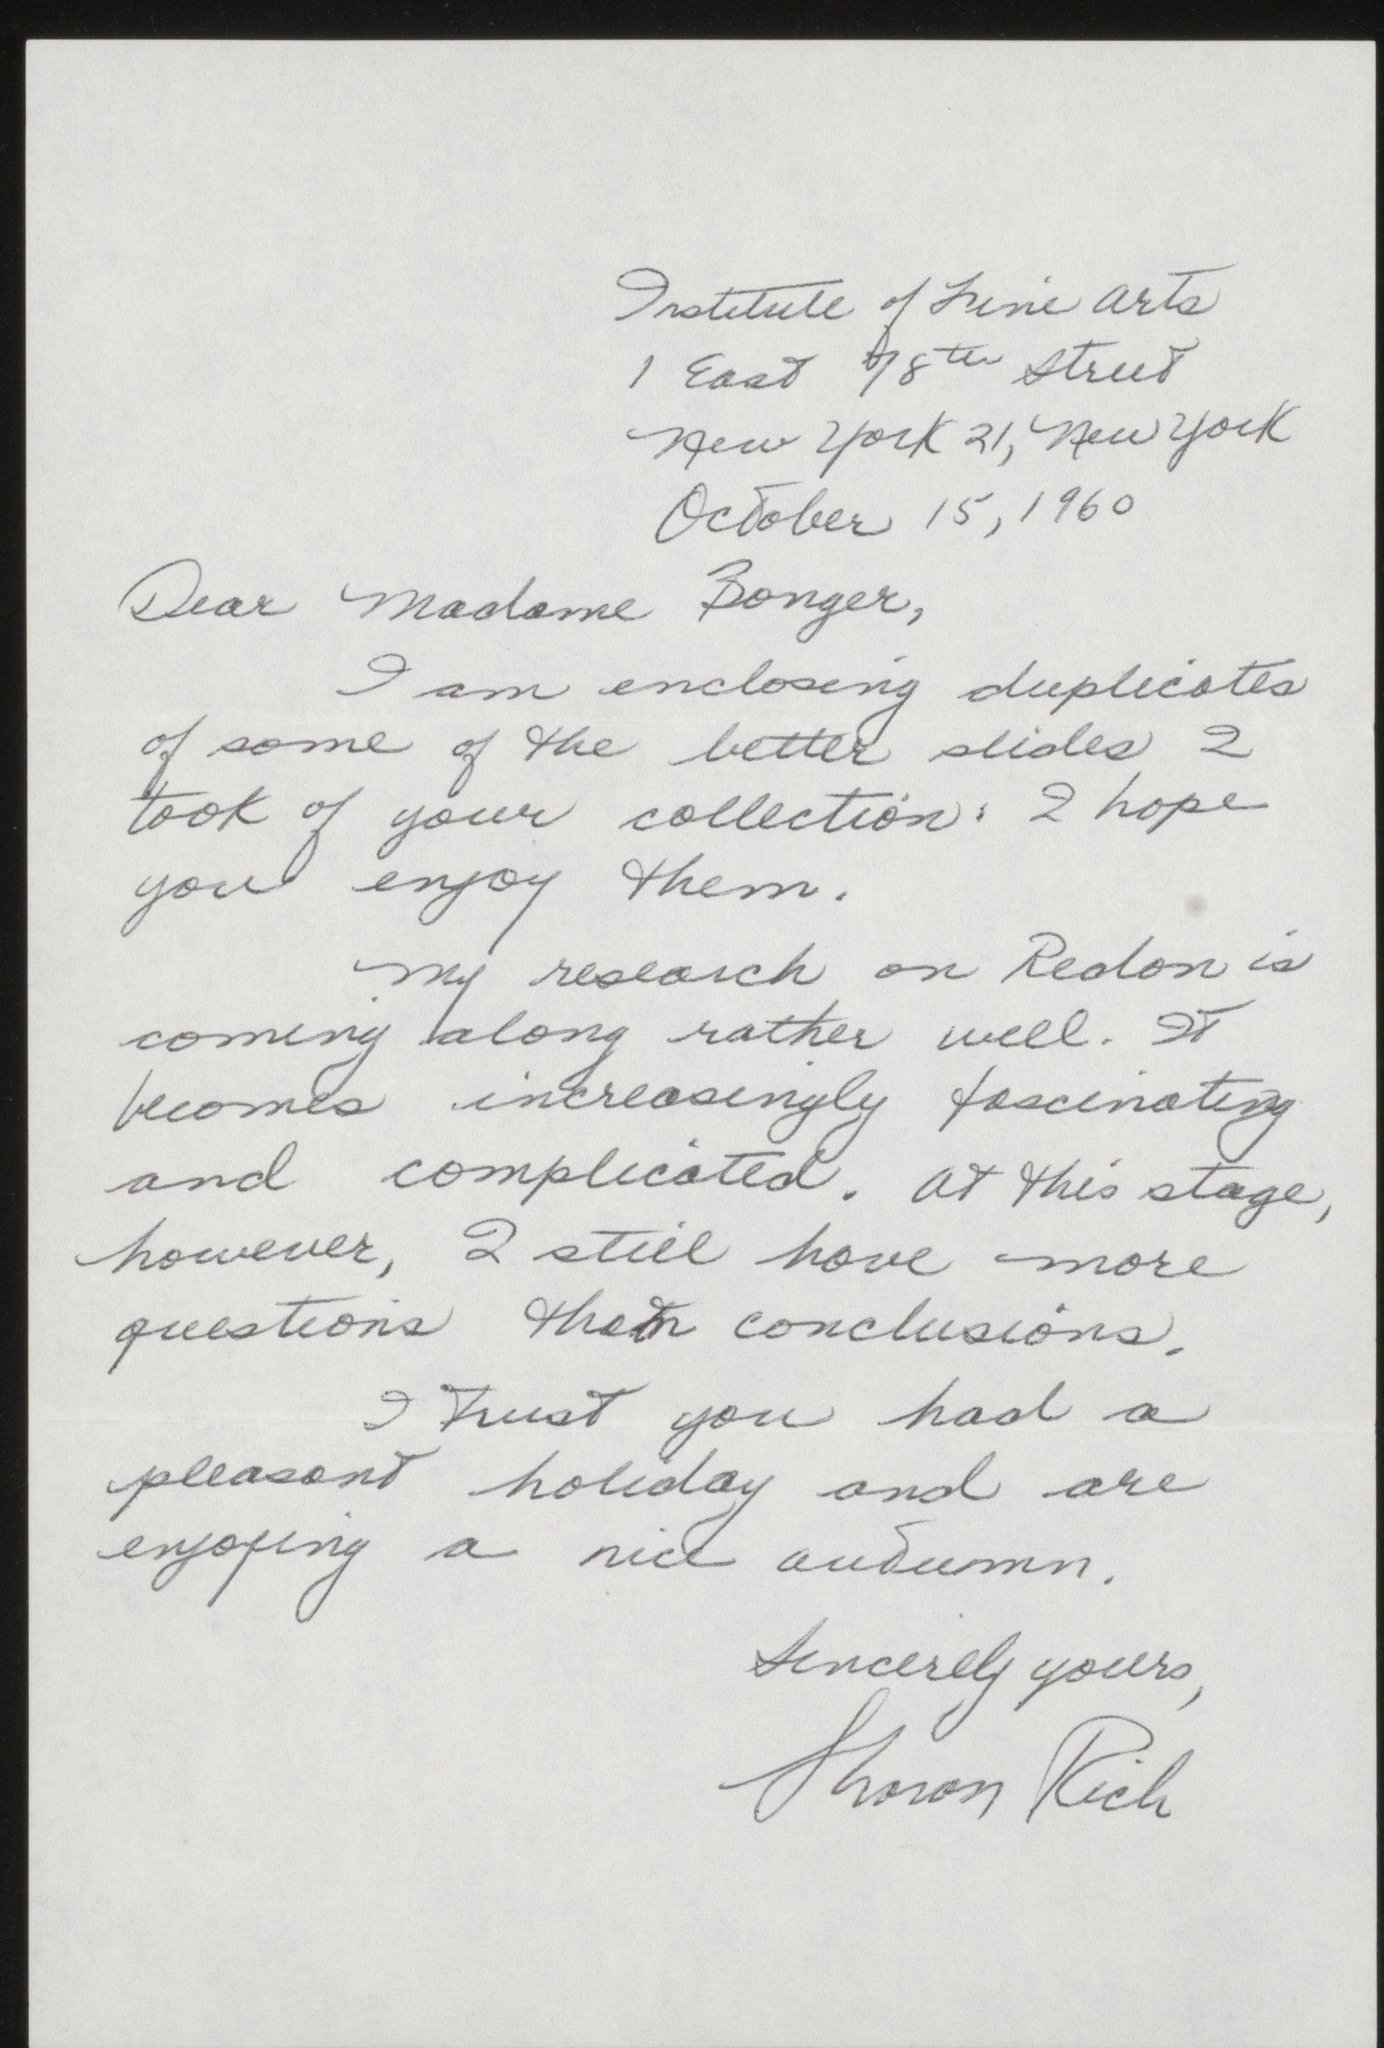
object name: letter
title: Brief aan Françoise W.M. Bonger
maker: sharon rich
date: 1960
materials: ink, paper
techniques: pen, writing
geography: new york city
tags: françoise w.m. bonger